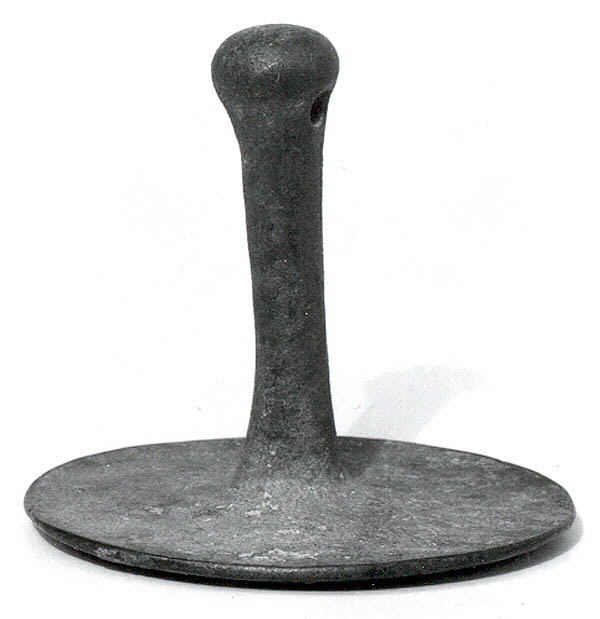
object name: cymbal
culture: hattian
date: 2300-2000 BCE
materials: bronze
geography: central anatolia